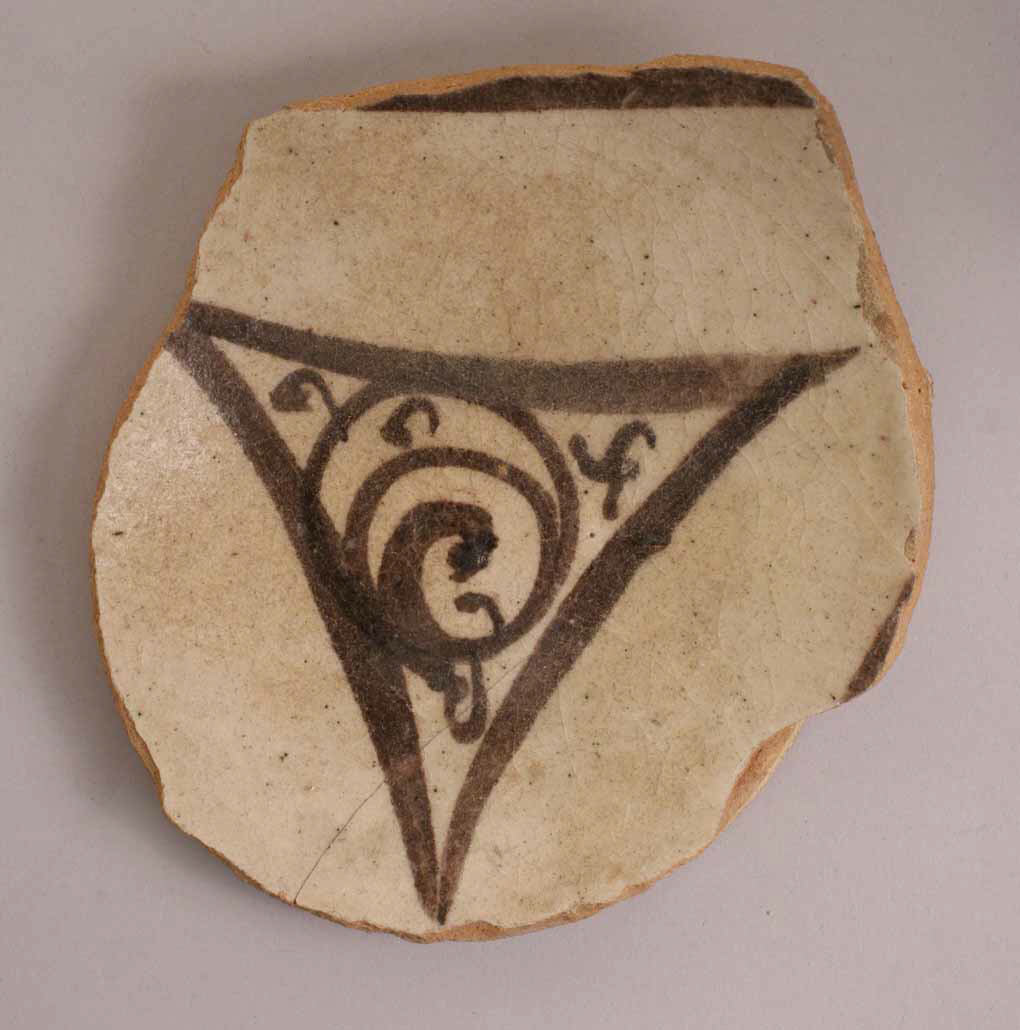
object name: ceramic fragment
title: Fragment of Dish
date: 1101-1300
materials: earthenware, glaze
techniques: painting, underglaze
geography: egypt or syria